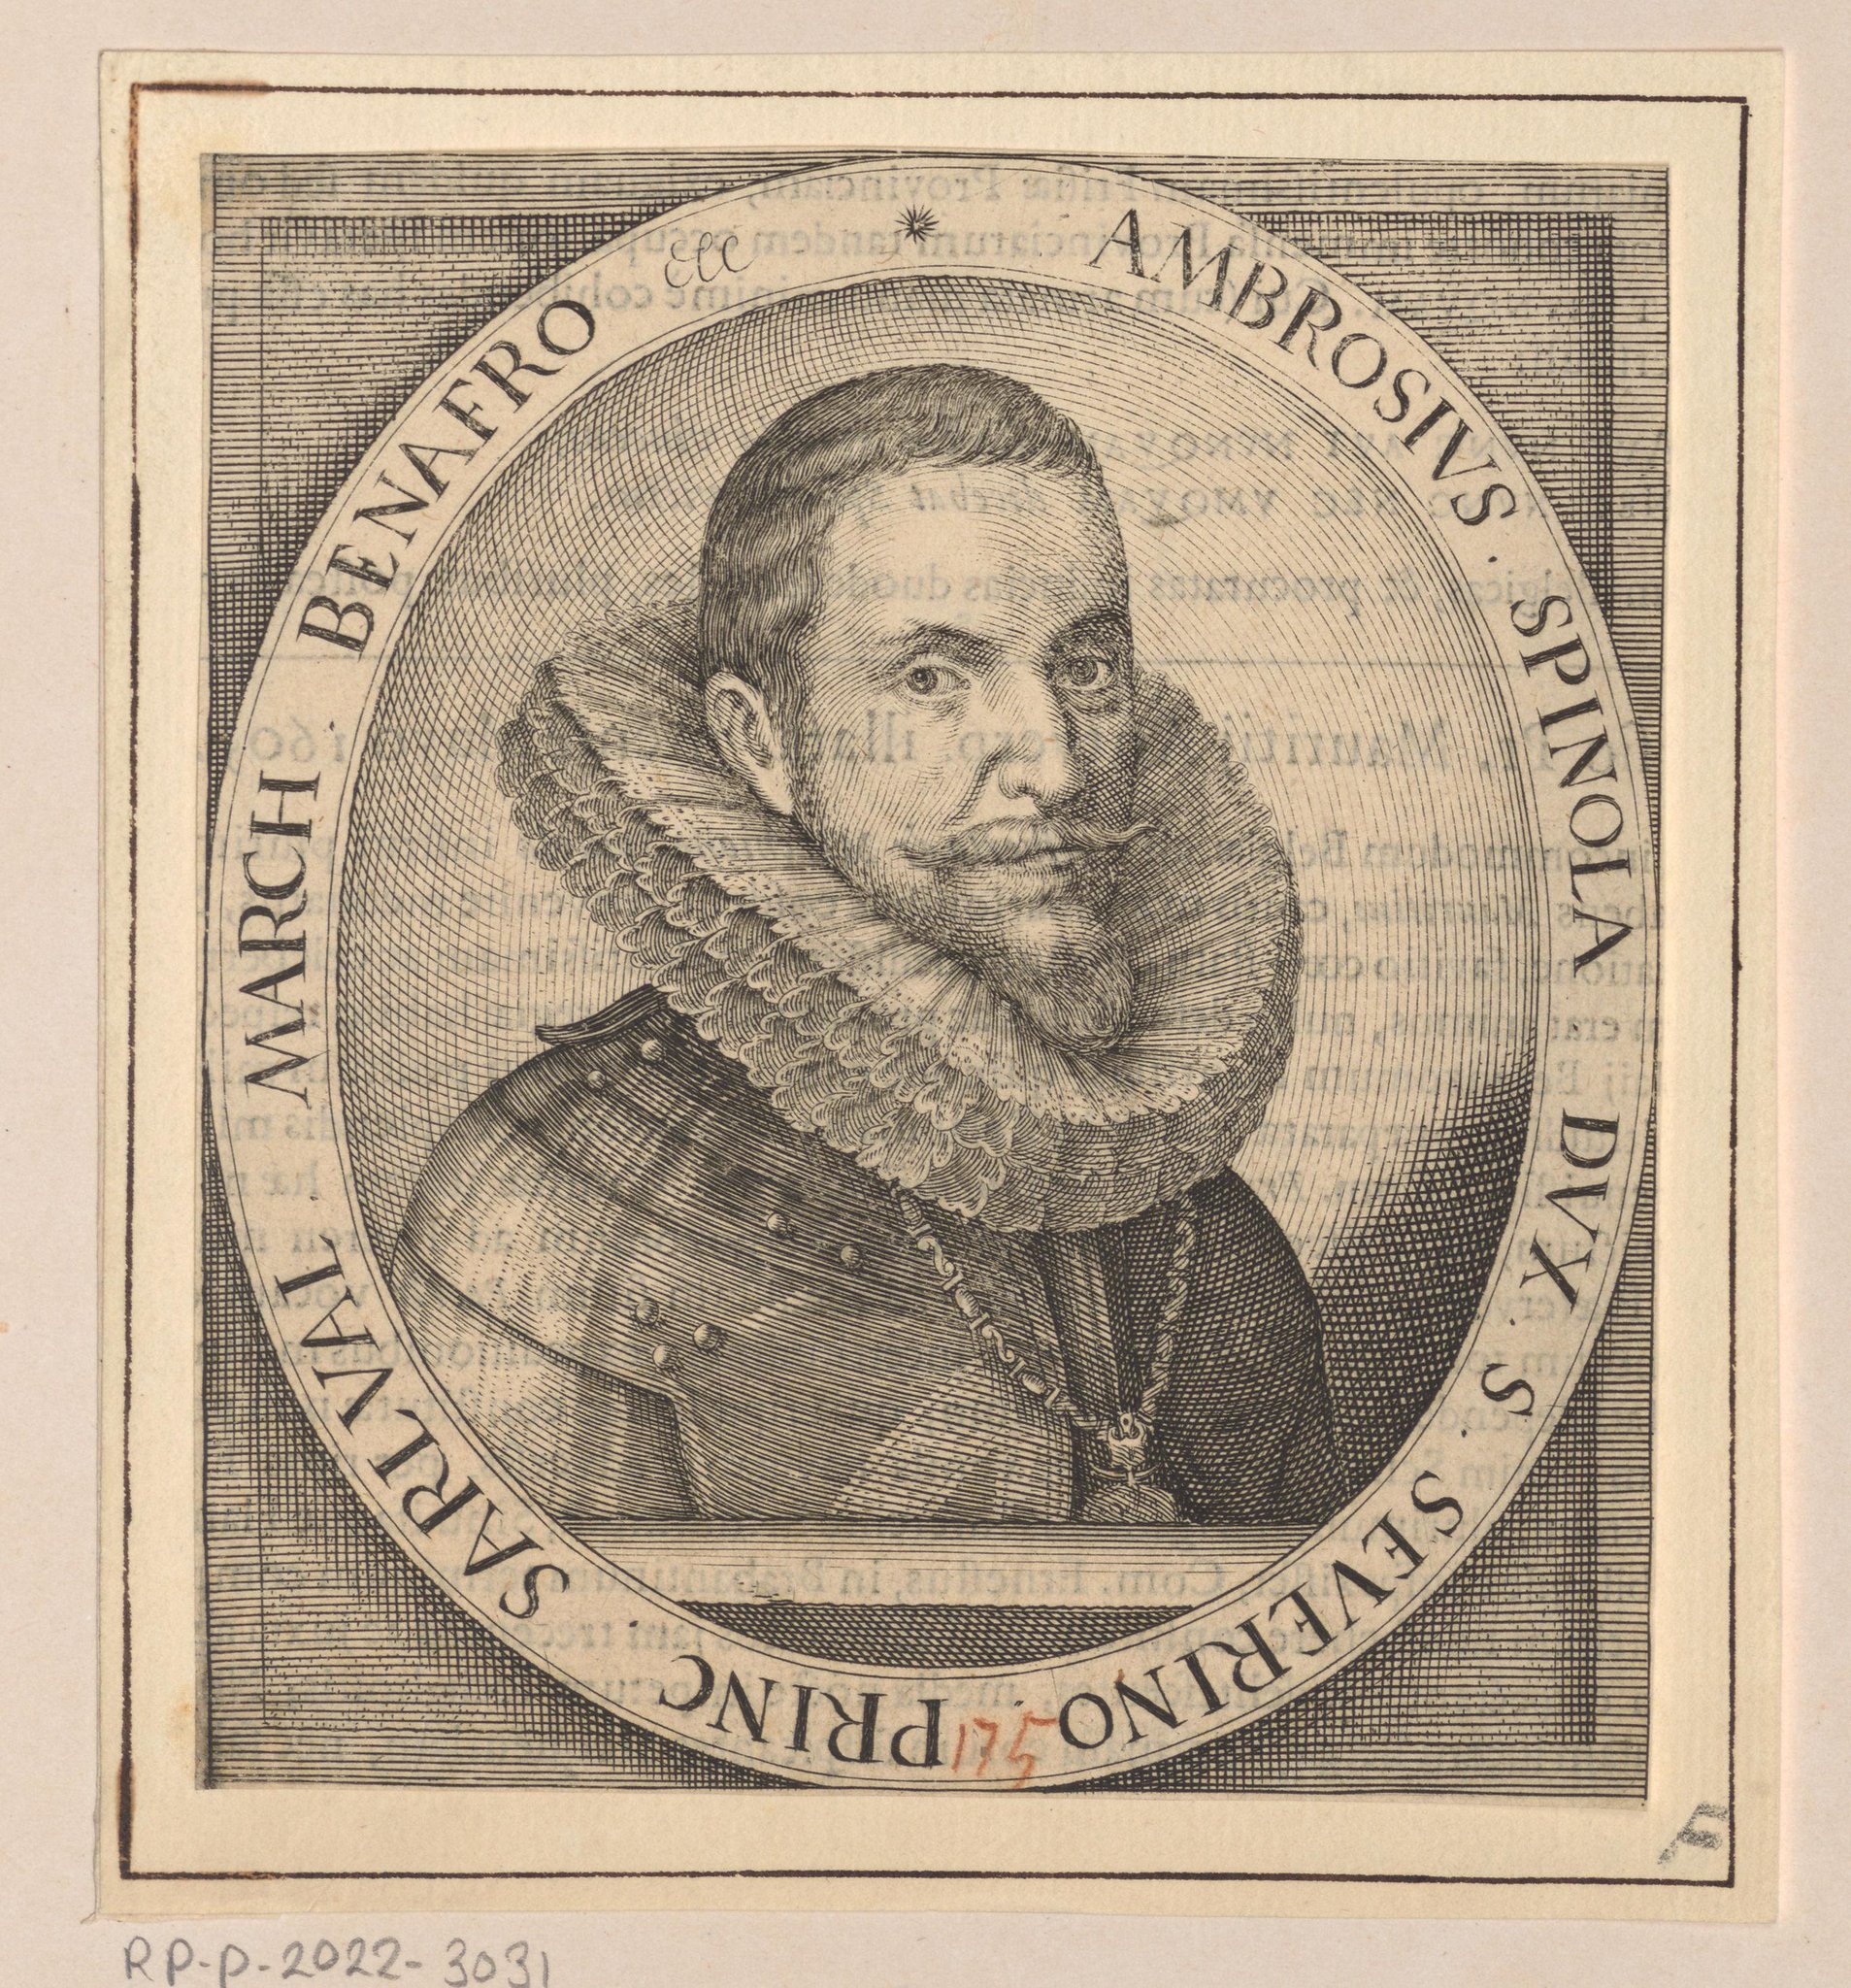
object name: print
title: Portret van Ambrogio Spinola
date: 1622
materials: ink, paper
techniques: engraving, letterpress printing, pen, snipping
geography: amsterdam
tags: commander-in-chief, general, marshal, historical persons, knighthood order of the golden fleece - insignia of a knighthood order, e.g.: badge, chain (with name of order)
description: Prent uit: Baudartius, Willem. Viva delineatio, ac descriptio omnium proeliorum, obsidionum, aliarumque rerum (...). Amsterdam: Michiel Colijn, 1622 [1522 foutief op titelpagina].